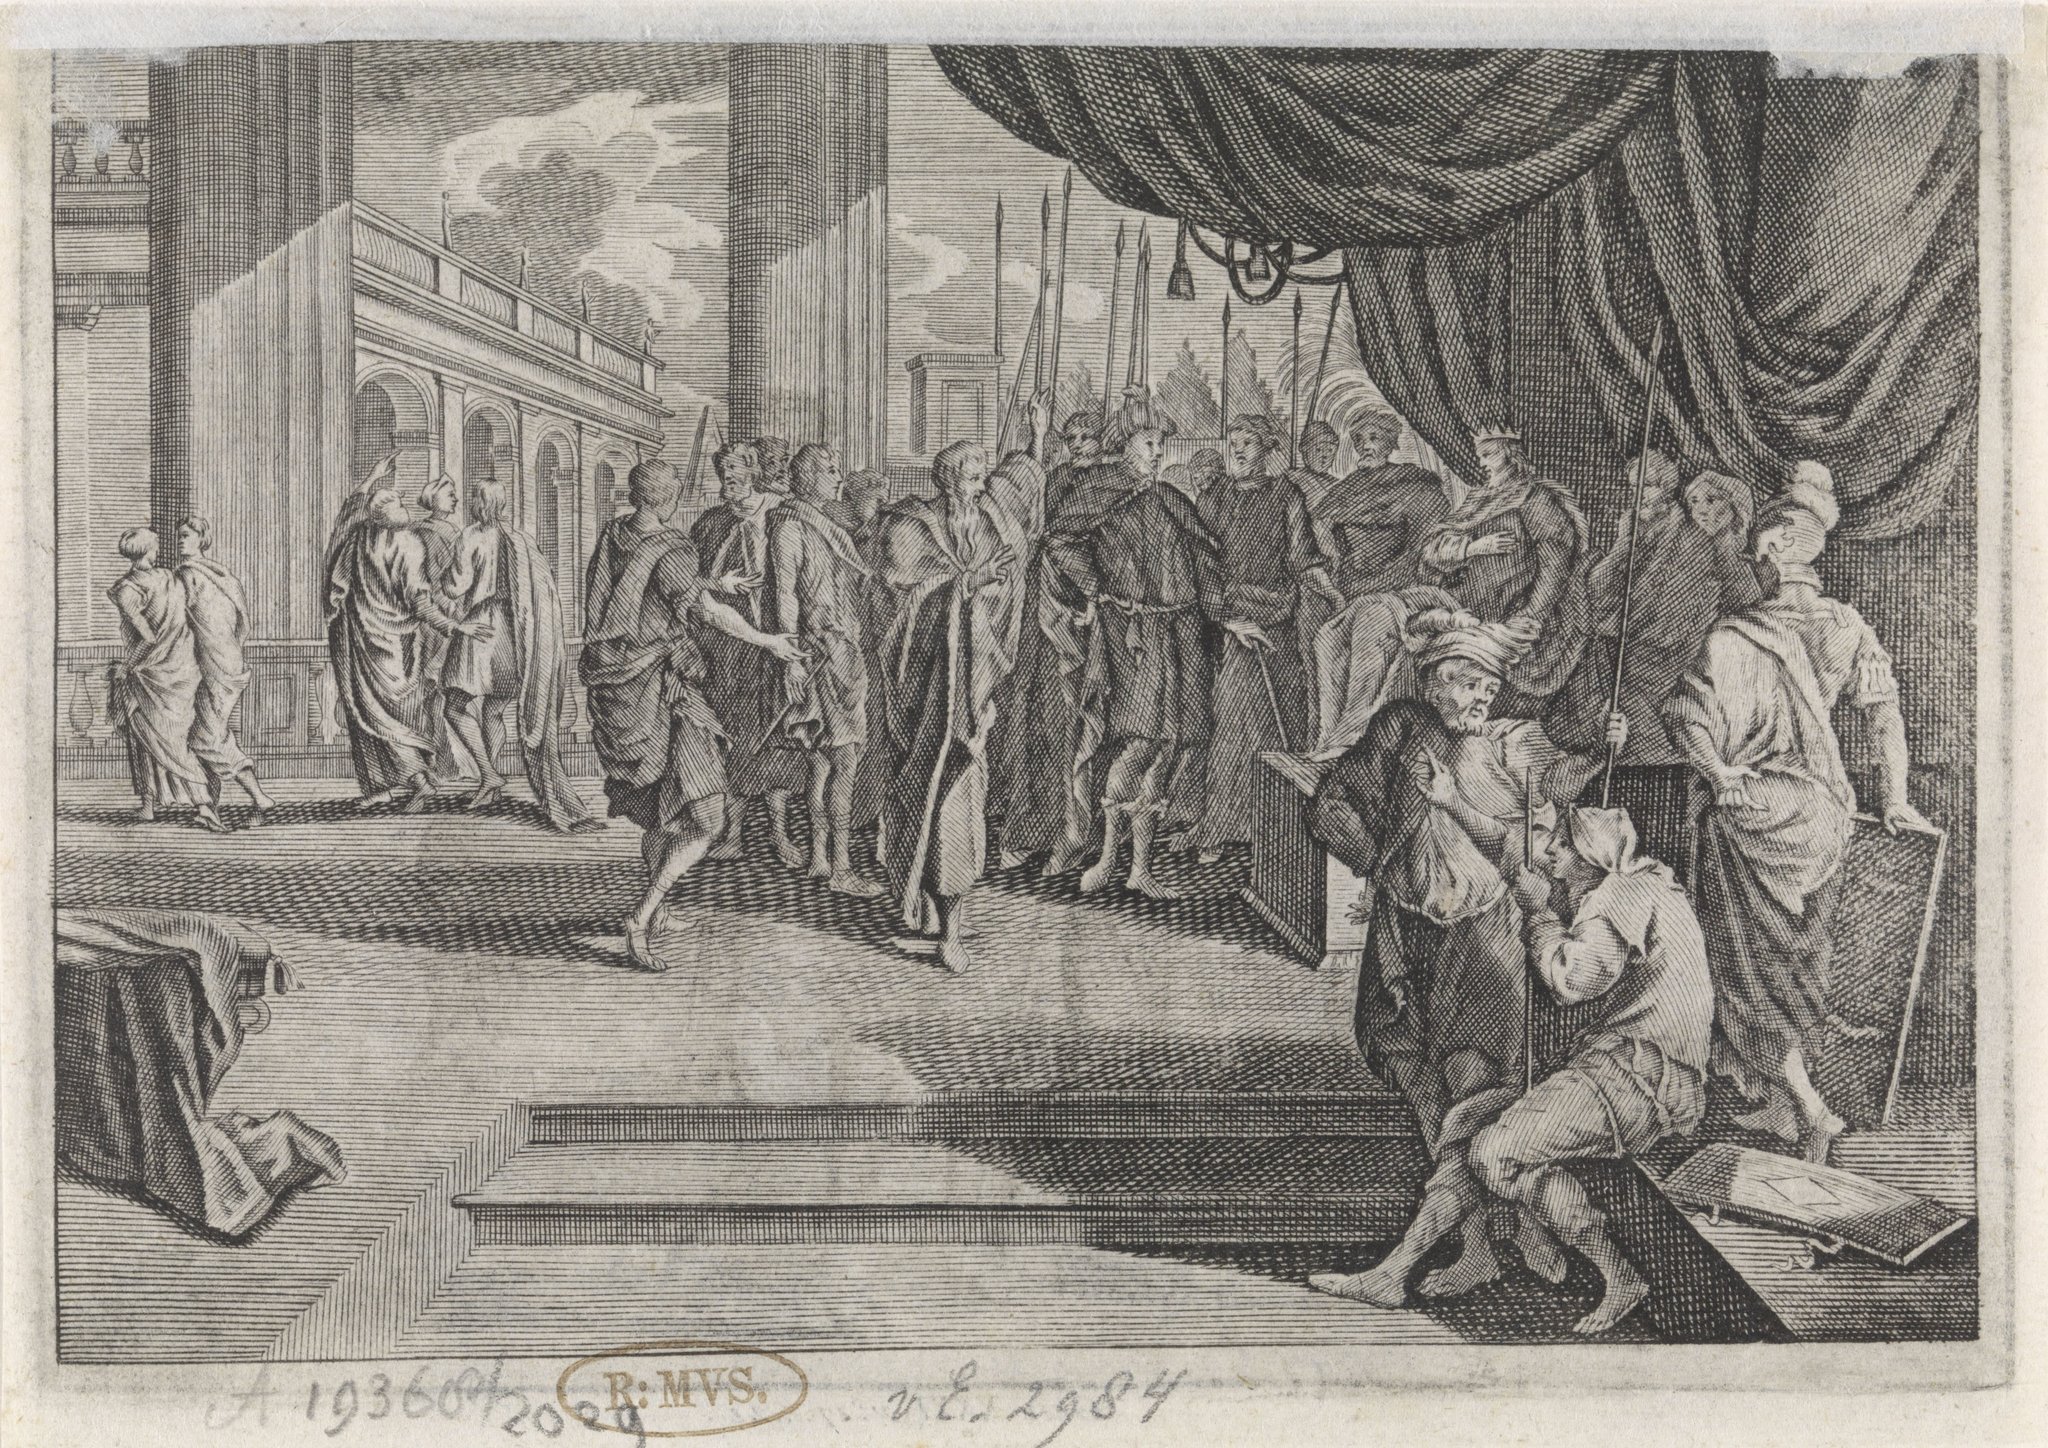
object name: book illustration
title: Voorstelling uit het Oude Testament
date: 1703-1762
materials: paper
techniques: etching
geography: haarlem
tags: genesis: the patriarchs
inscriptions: collector's mark: Lugt 2228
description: De prent op het verso komt een eerste keer voor als boekillustratie voor David Martin. Historie des Ouden en Nieuwen Testaments. Amsterdam, Pieter Mortier, 1703. Deel I. De boekillustraties voor de Mortierbijbel hebben verschillende staten en kopieën, waarbij de chronologische volgorde moeilijk te achterhalen valt. Als boekillustraties werden ze bovendien herhaaldelijk opnieuw gebruikt voor andere boekwerken.